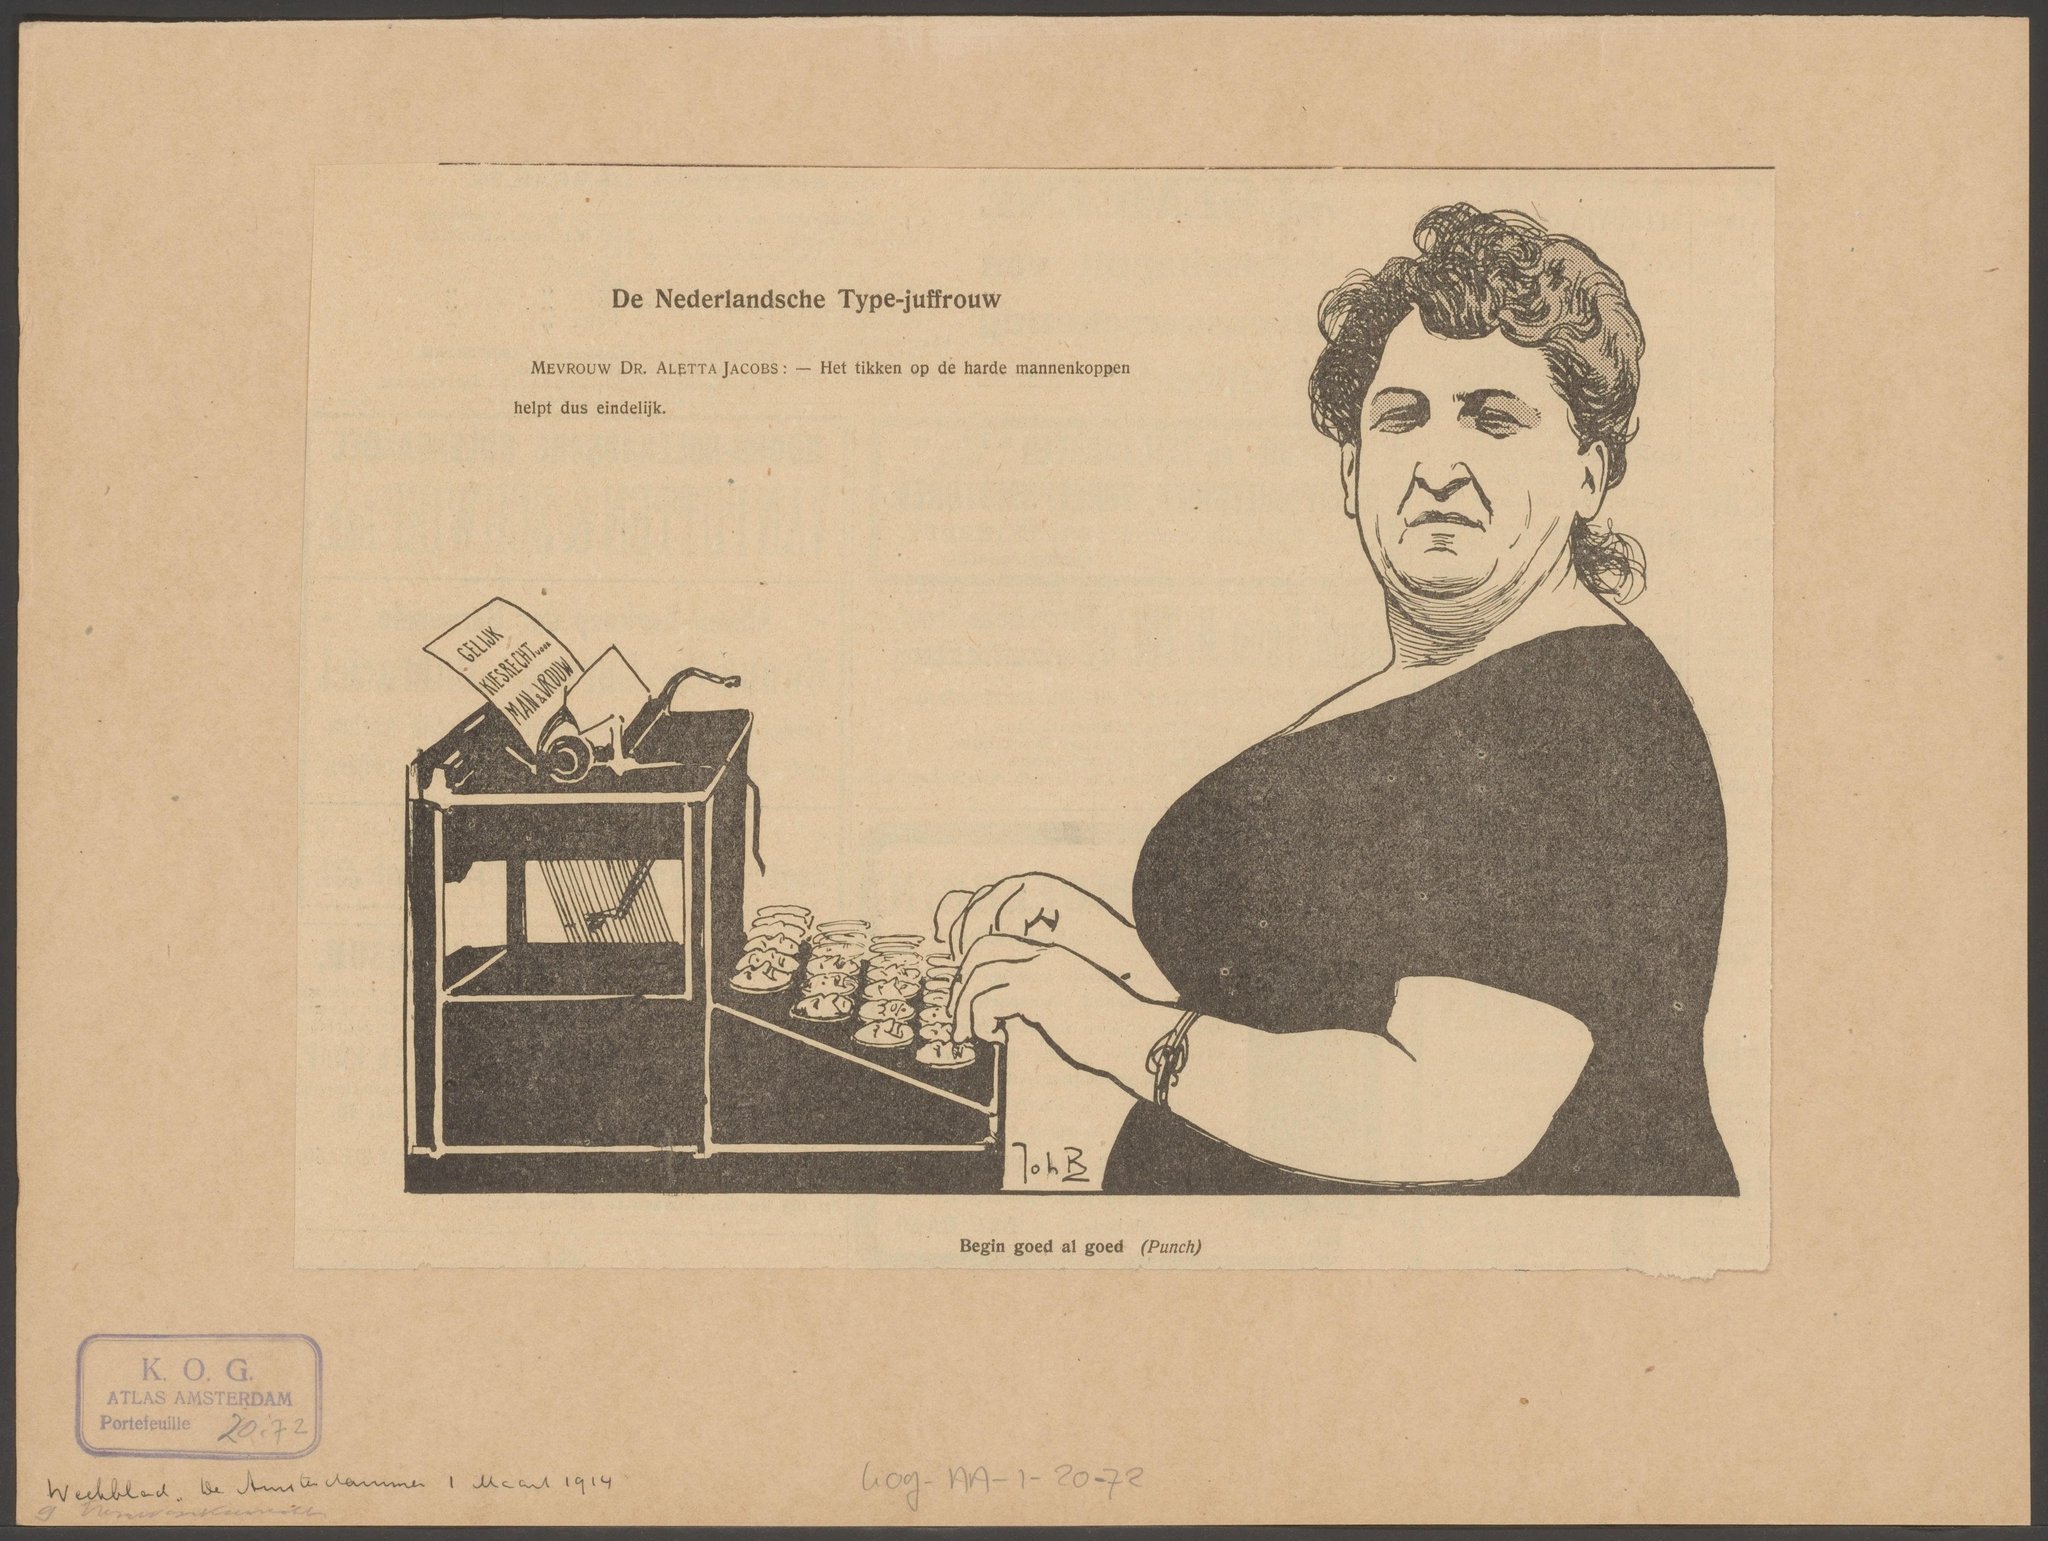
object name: photomechanical print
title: De Nederlandsche Type-juffrouw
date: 1914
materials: paper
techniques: letterpress printing, line block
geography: netherlands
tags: political enfranchisement of women, women's liberation, typewriter, political caricatures and satires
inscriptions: collector's mark: Lugt 1641b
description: Prent uit: De Amsterdammer 38 (1914), nr. 1914, 1 maart 1914, nr. 11.